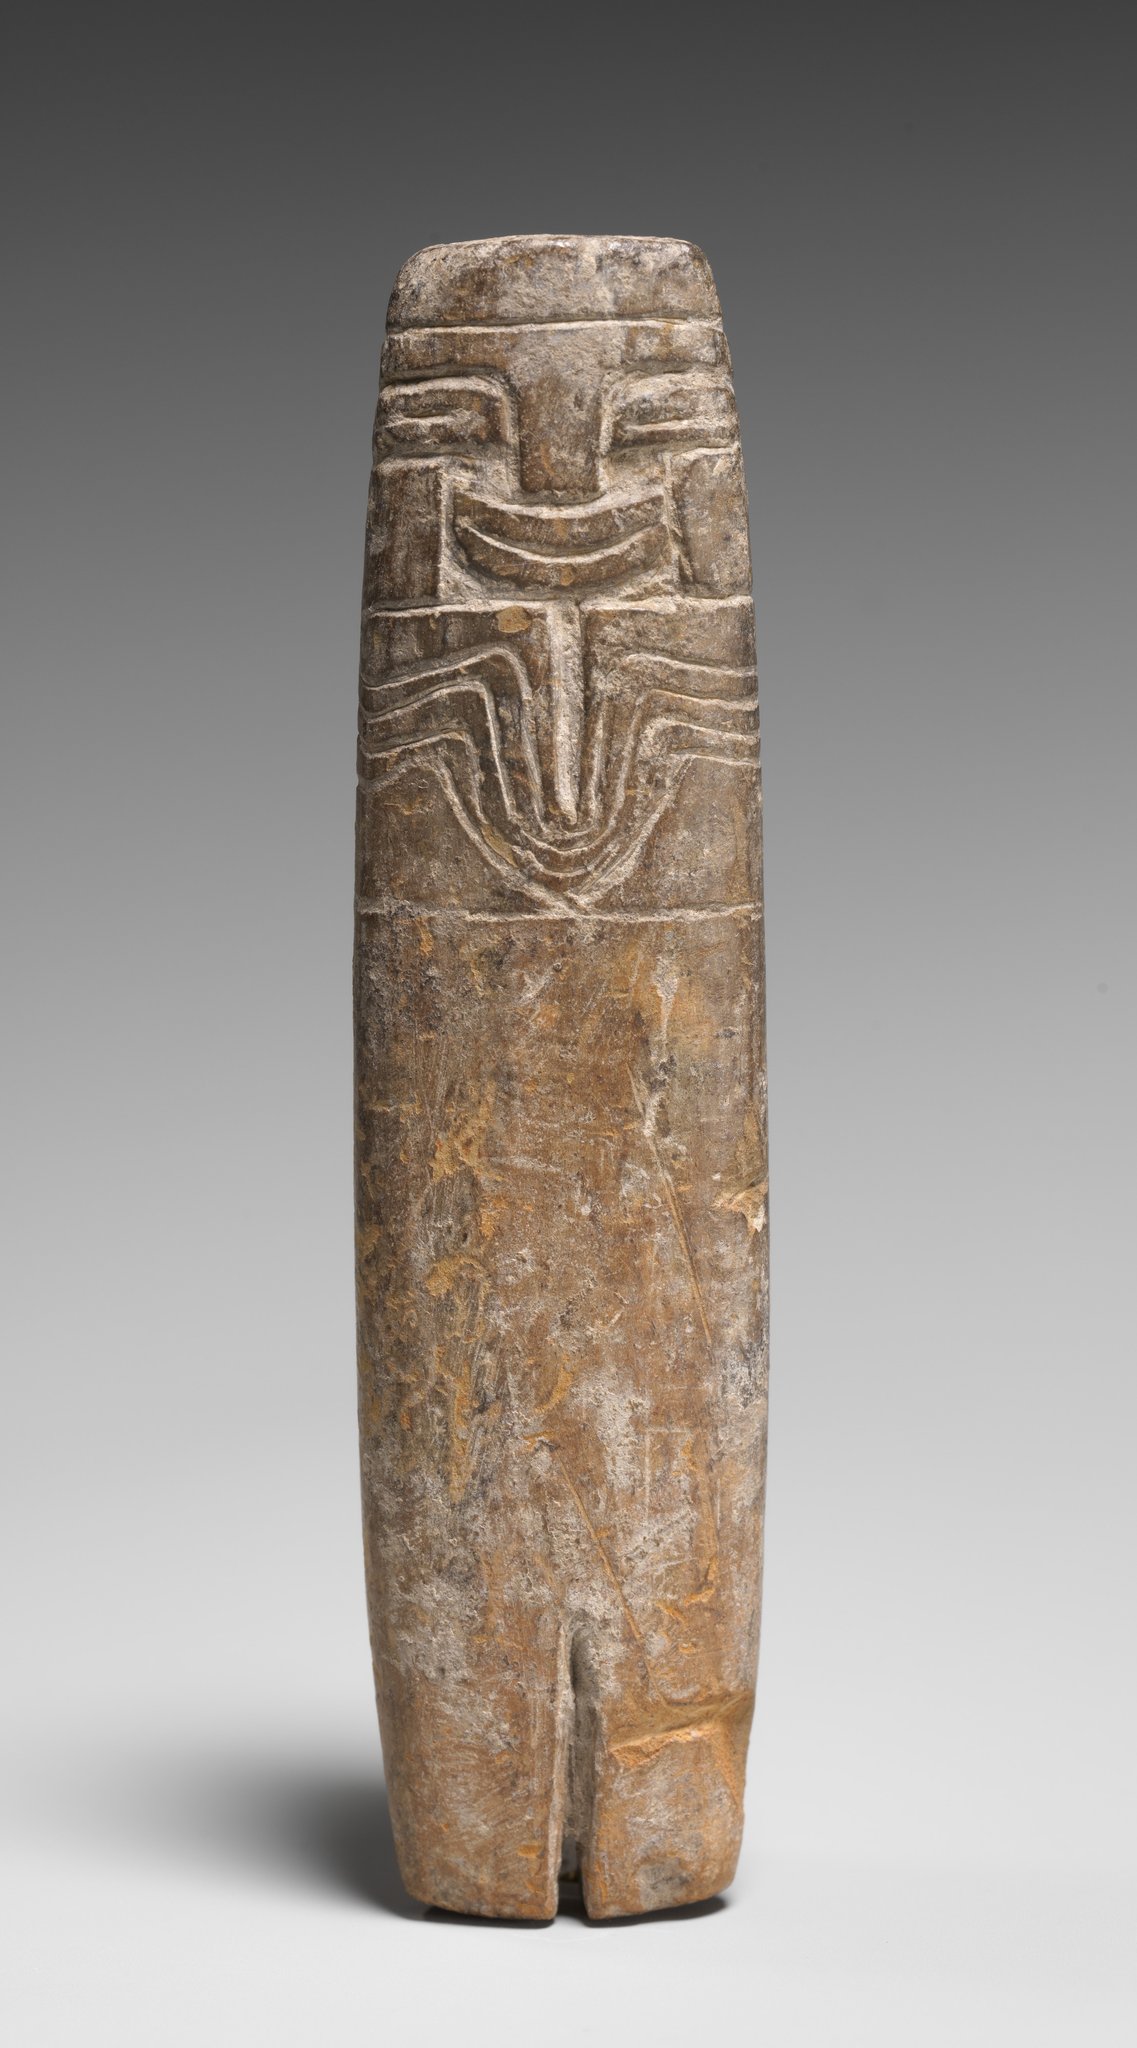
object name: human figure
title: Abstract Stone Figure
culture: valdivia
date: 2333-2001 BCE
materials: stone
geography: ecuador